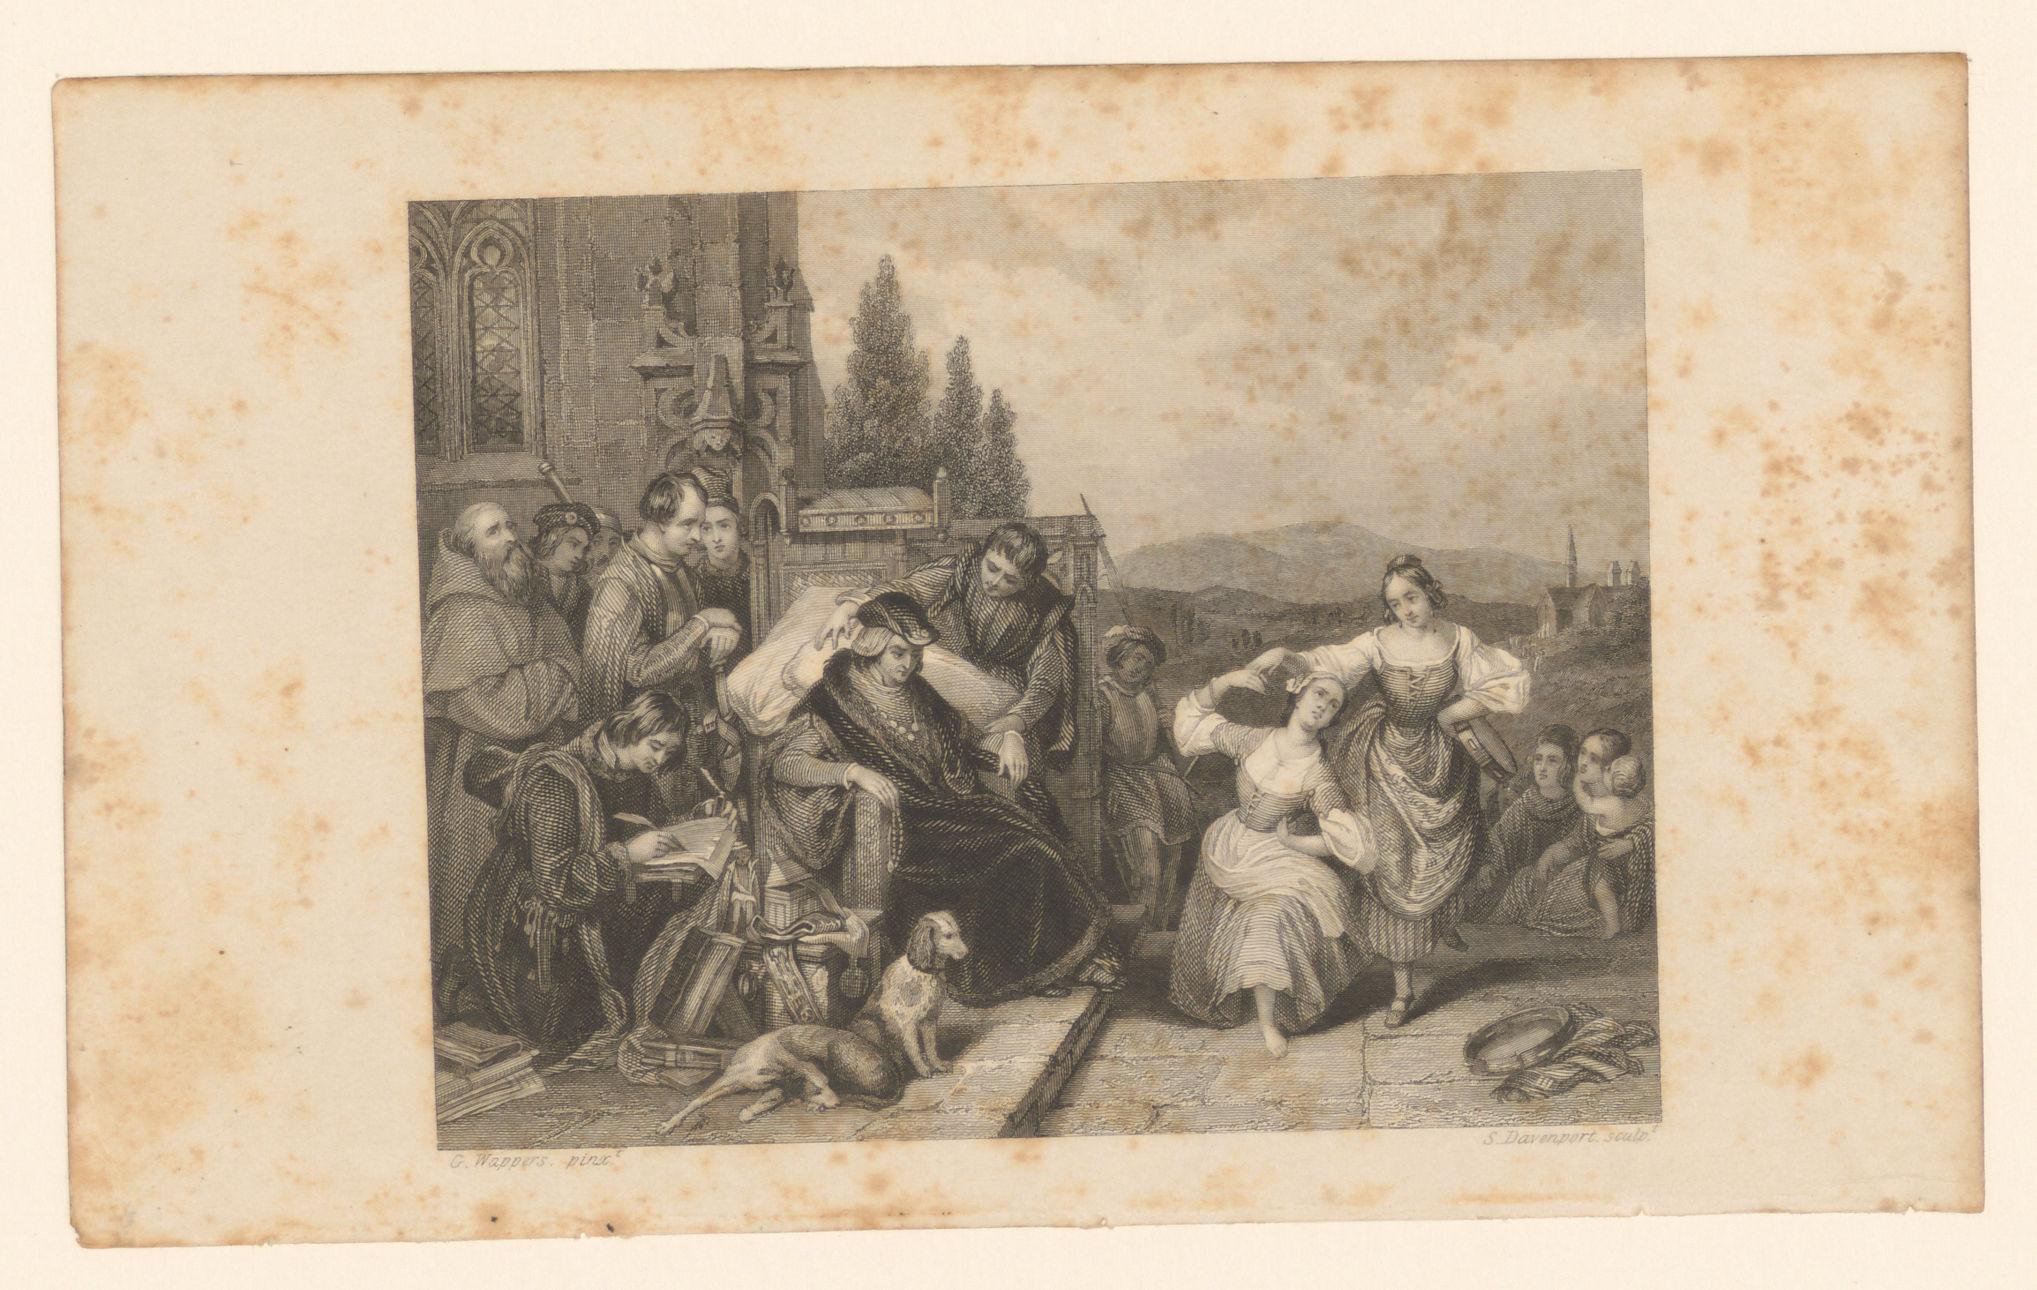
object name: print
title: Man op een troon met een vrouw aan zijn voeten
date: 1793-1842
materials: paper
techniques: engraving, etching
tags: throne, ruler, sovereign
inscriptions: collector's mark: Lugt 2228